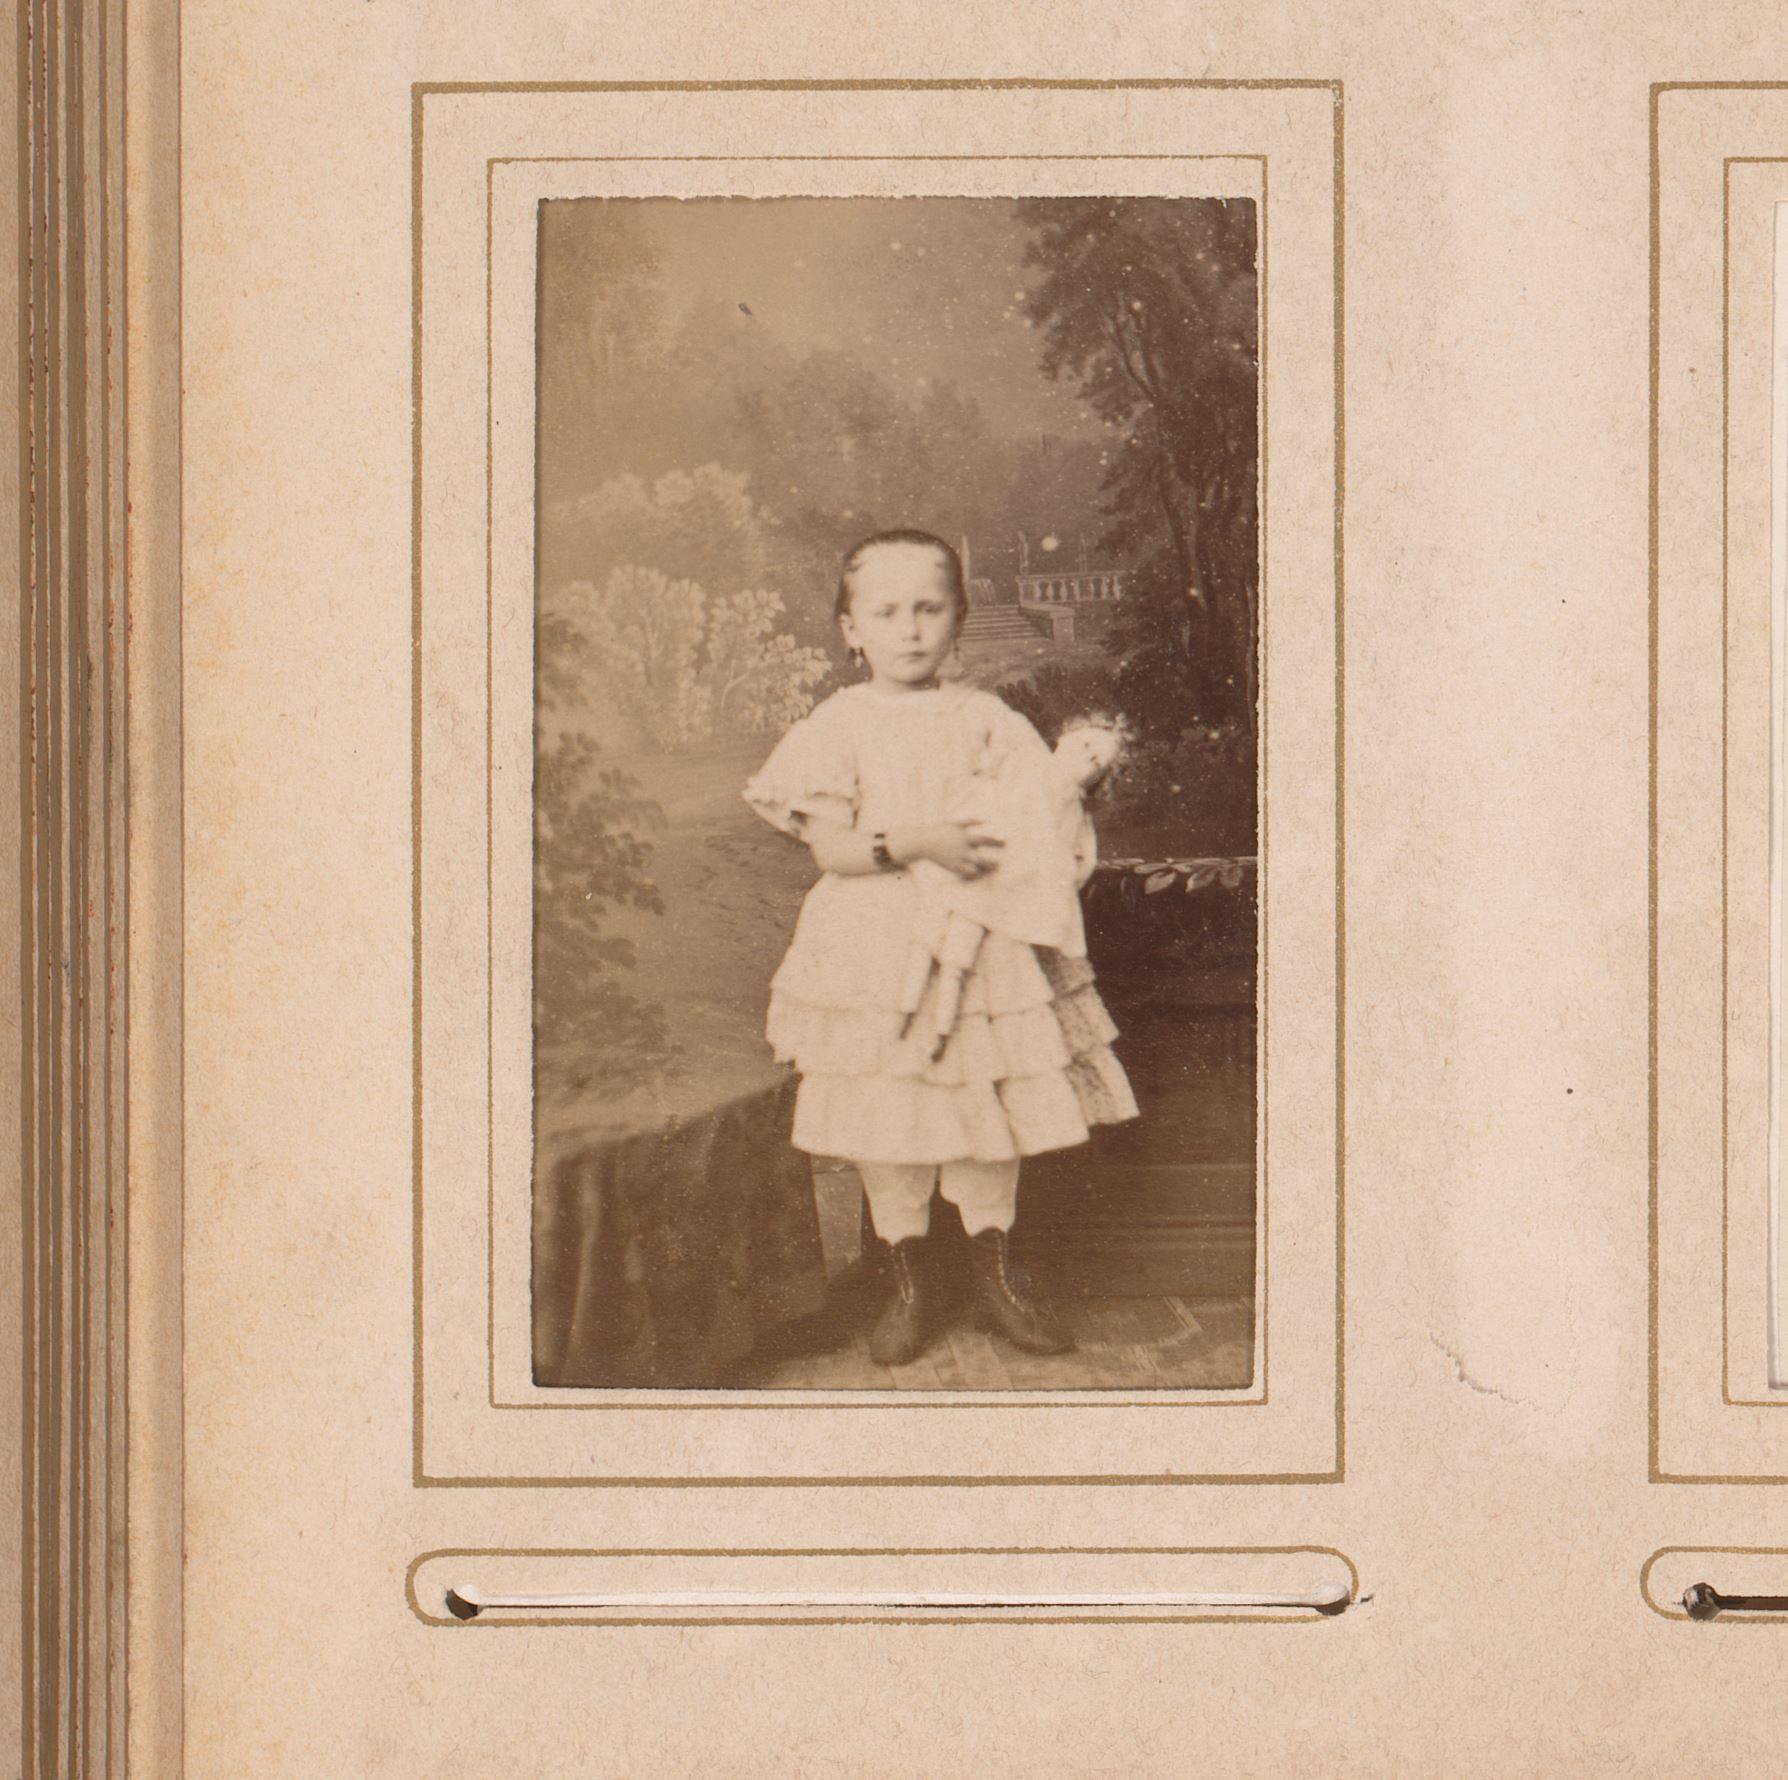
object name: carte de visite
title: Portret van een meisje met pop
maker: roelof loots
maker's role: fotograaf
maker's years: 1814-1898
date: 1860-1890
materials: cardboard, photographic support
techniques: albumen print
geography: medemblik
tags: historical persons - bb - woman, girl (child between toddler and youth), (playing with) dolls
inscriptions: inscription: ‘Atelier photographique/ R. Loots/ Nieuwstraat/ Medemblik’